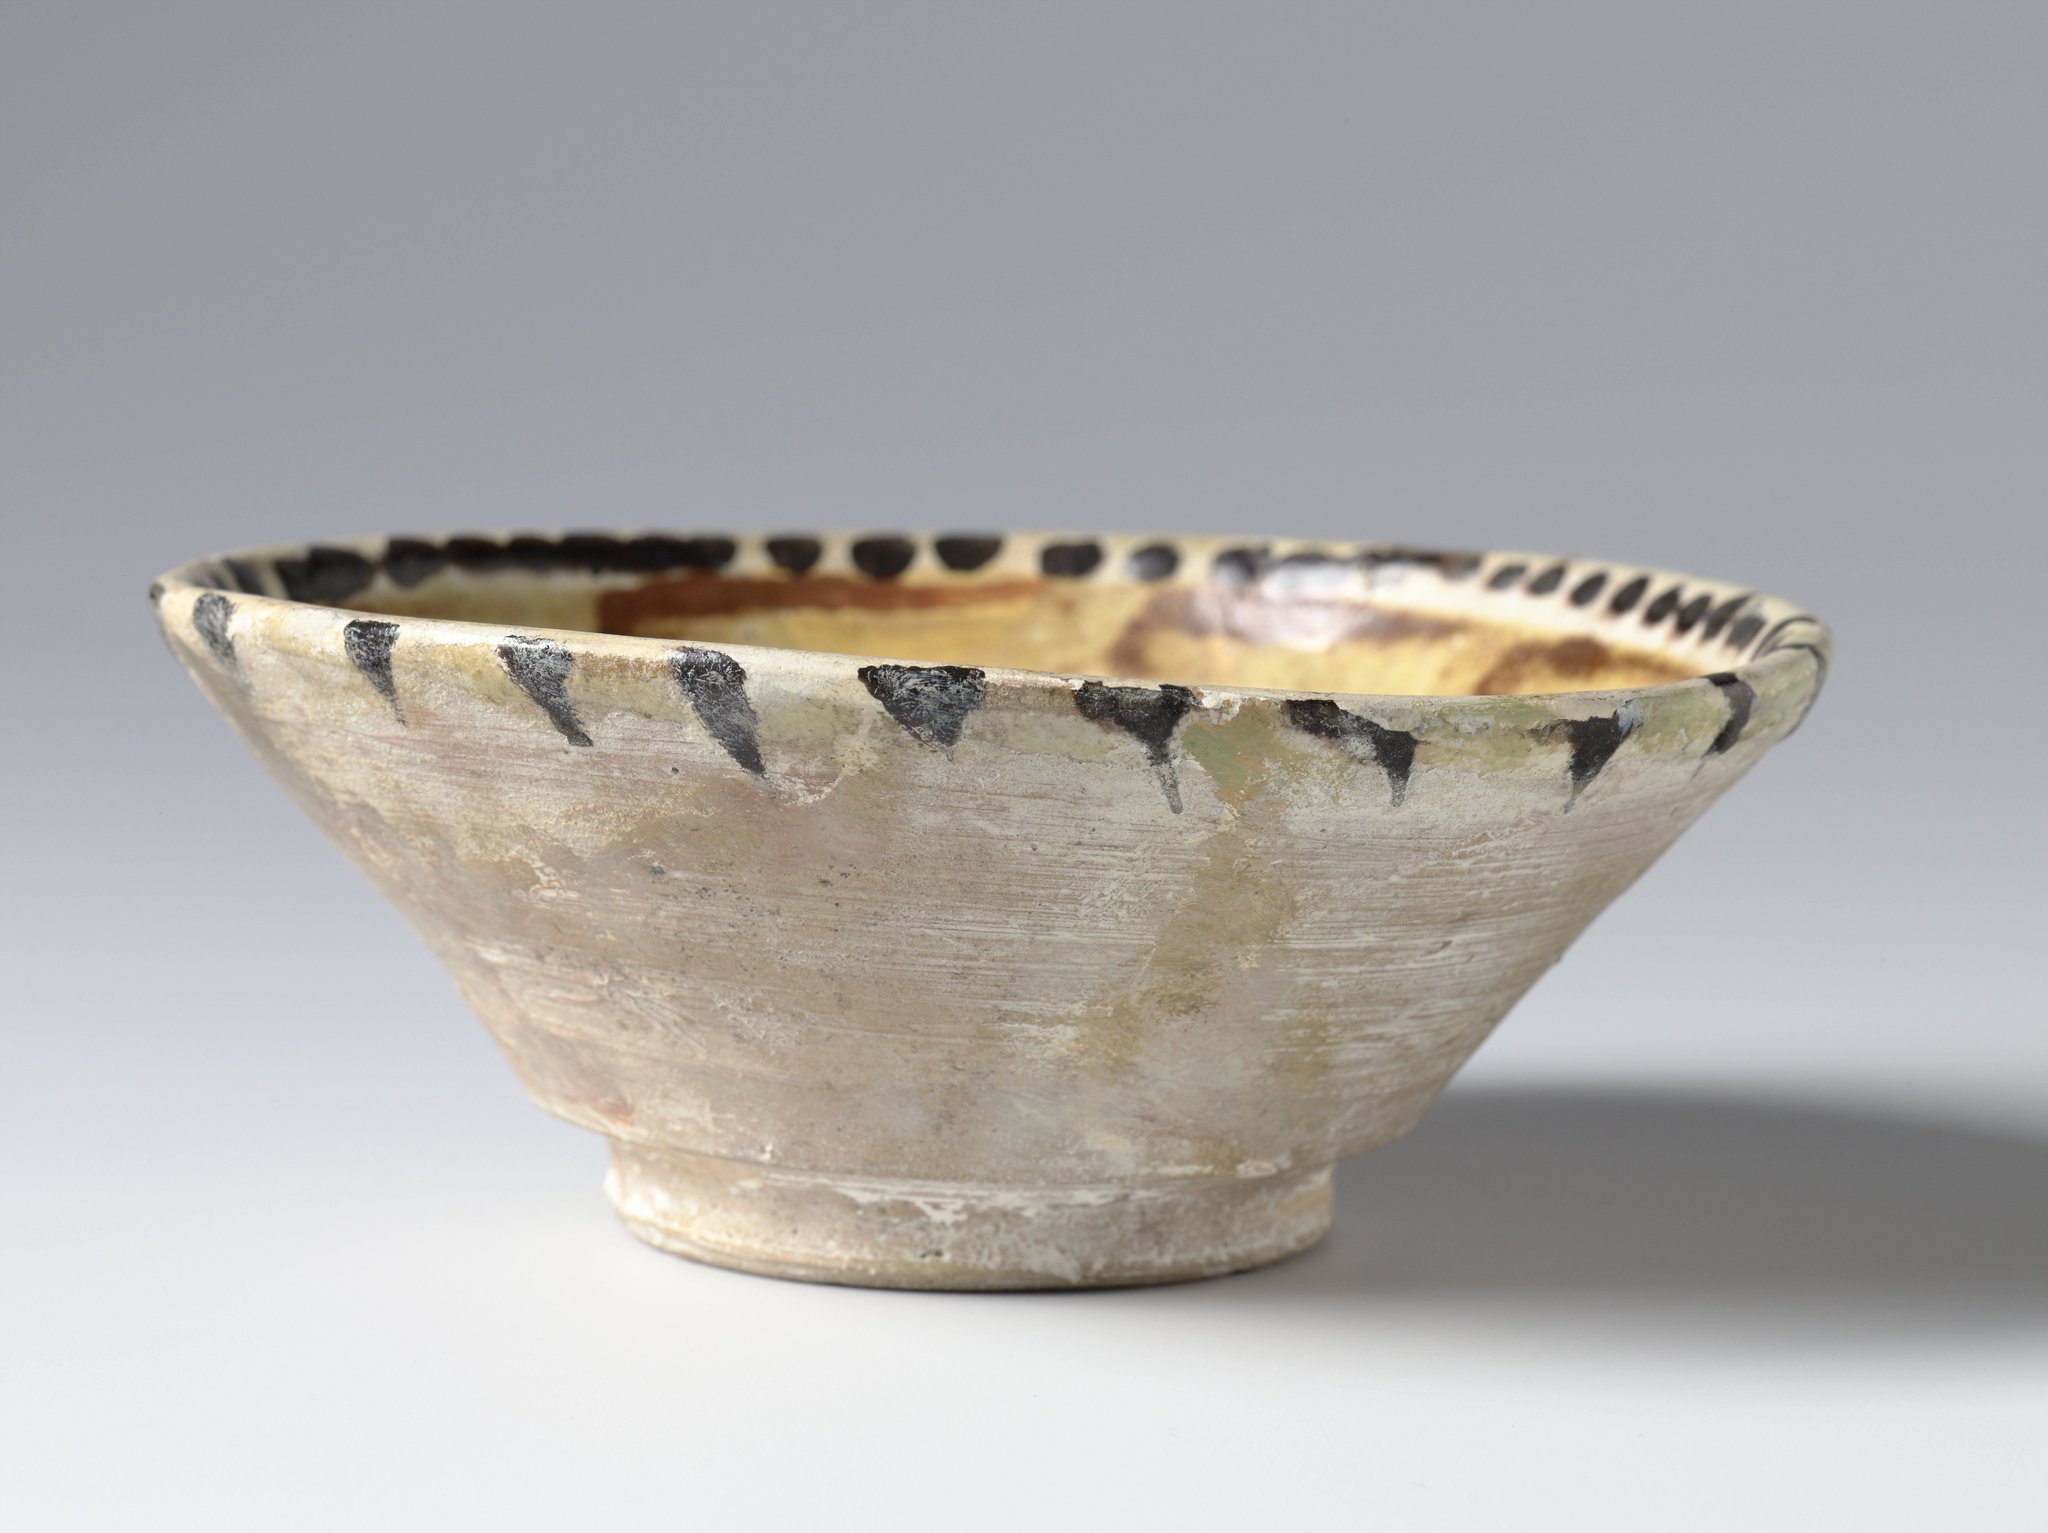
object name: bowl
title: Bowl with ornamental borders and scrolls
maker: Anonymous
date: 900-1099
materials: earthenware, glaze, paint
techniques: firing, turning, vitrification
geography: iran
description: Kom van aardewerk gedecoreerd met zwarte en bruine slib op engobe van witte slib. Op de binnenwand een band met krulwerk. Daarboven een bruine band en op de binnenrand een band met stippen. De buitenrand met afhangende driehoeken.